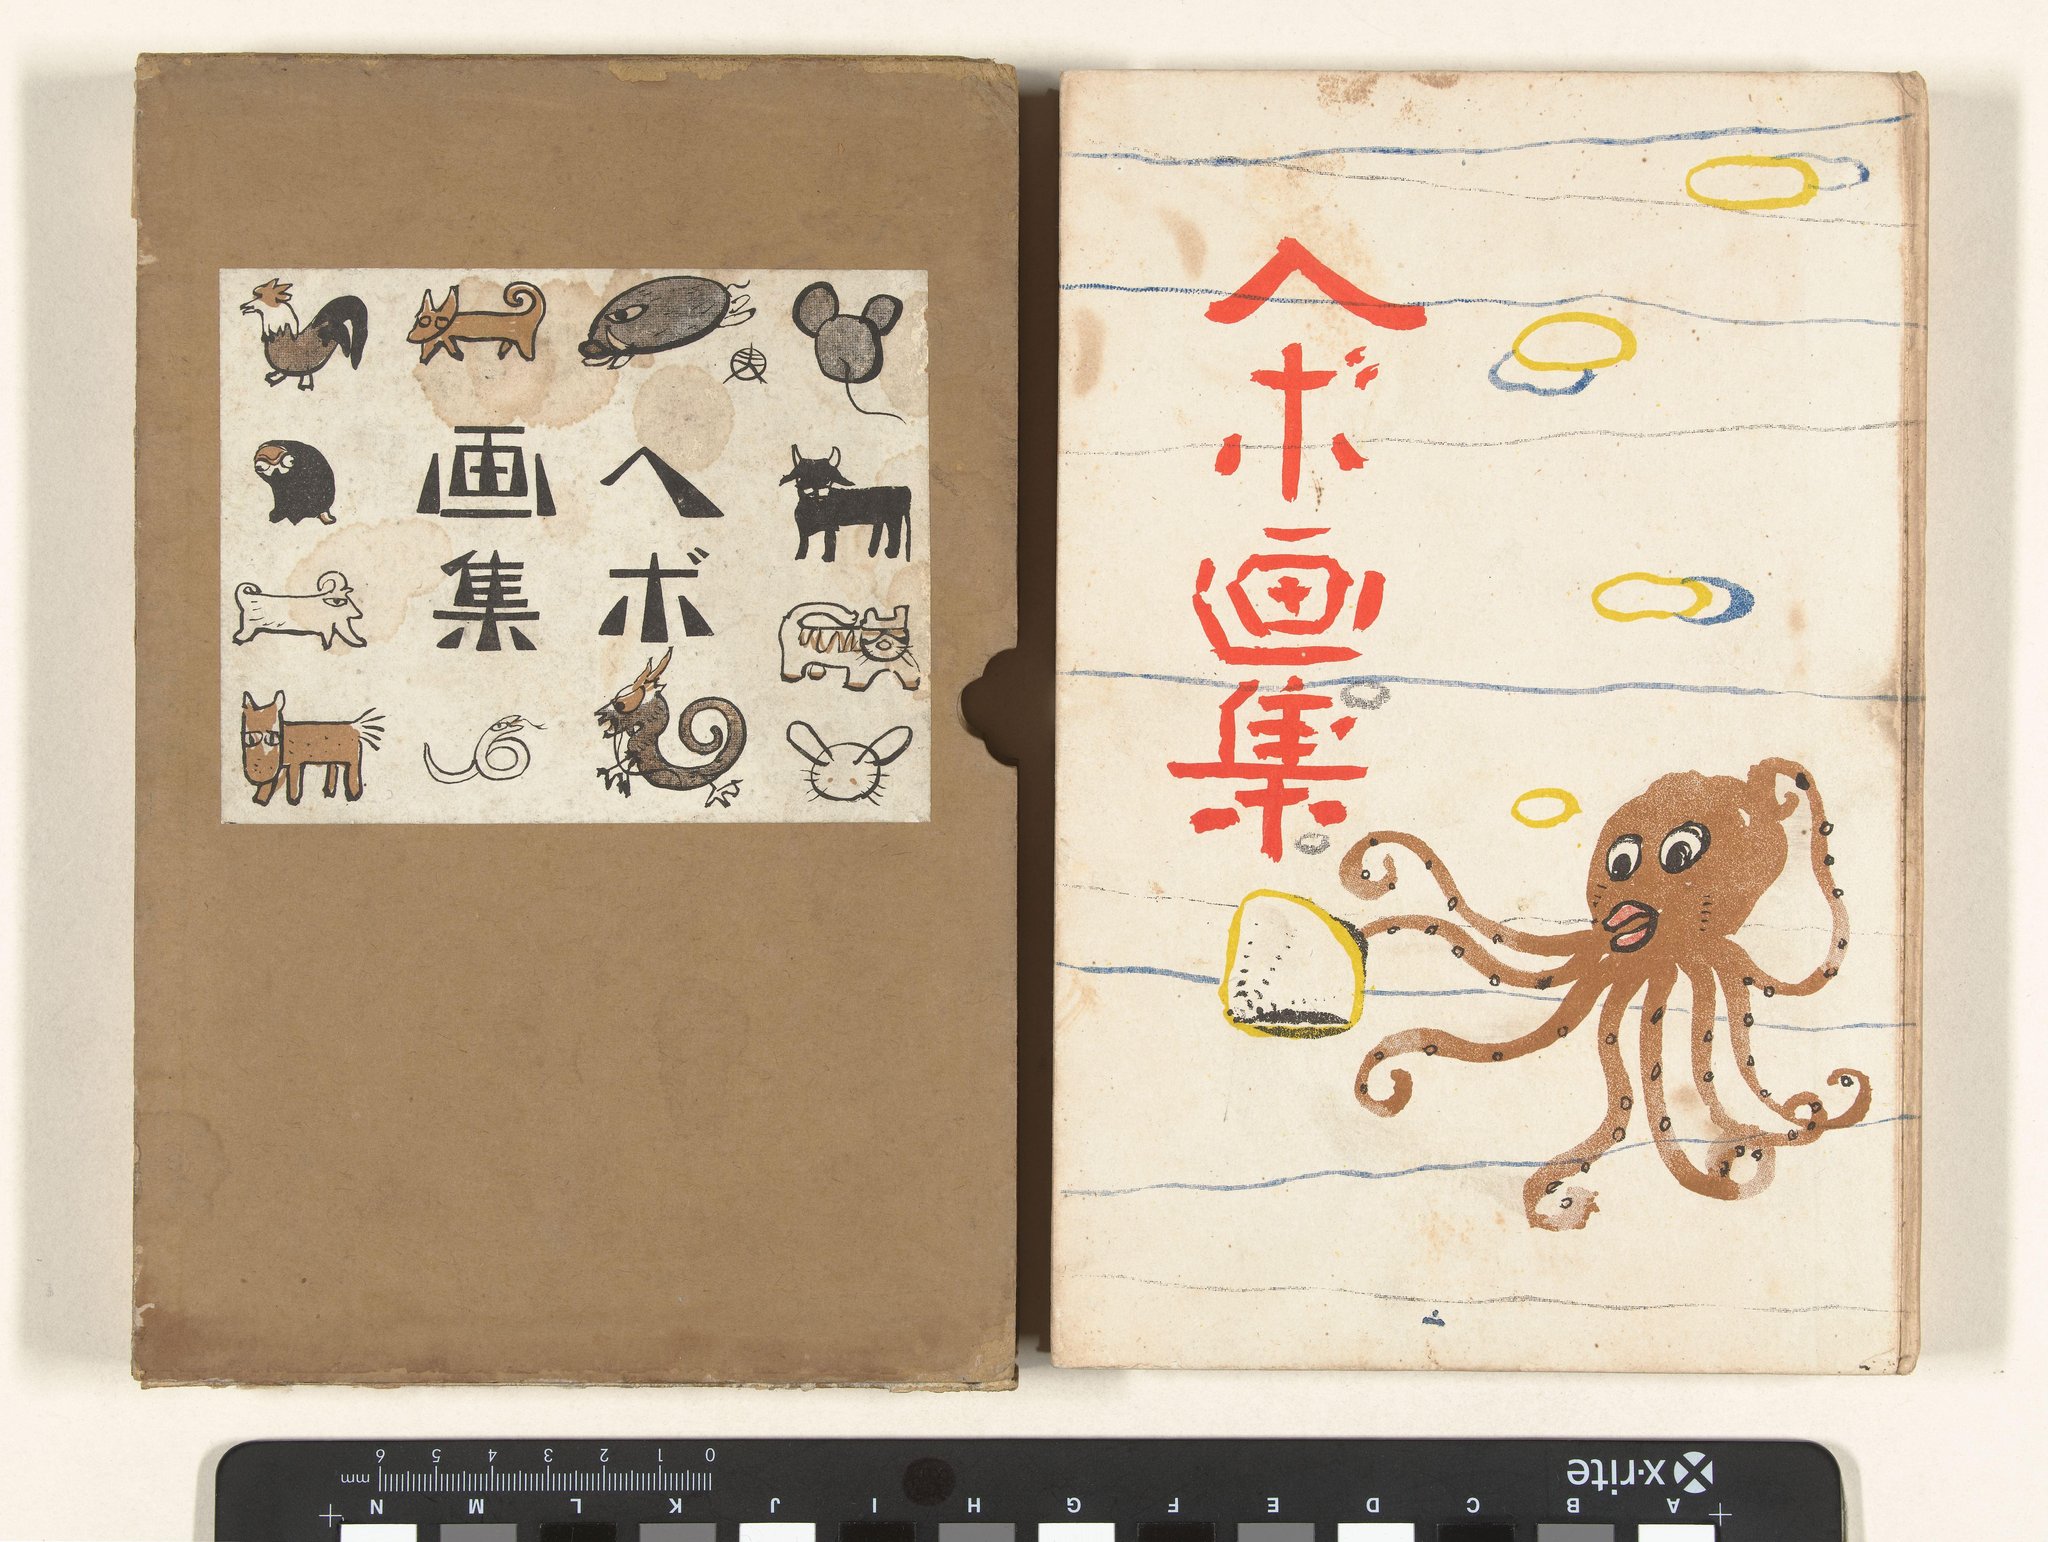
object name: book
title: Hebo gashu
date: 1912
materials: paper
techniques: woodcut, letterpress printing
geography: tokyo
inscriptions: date